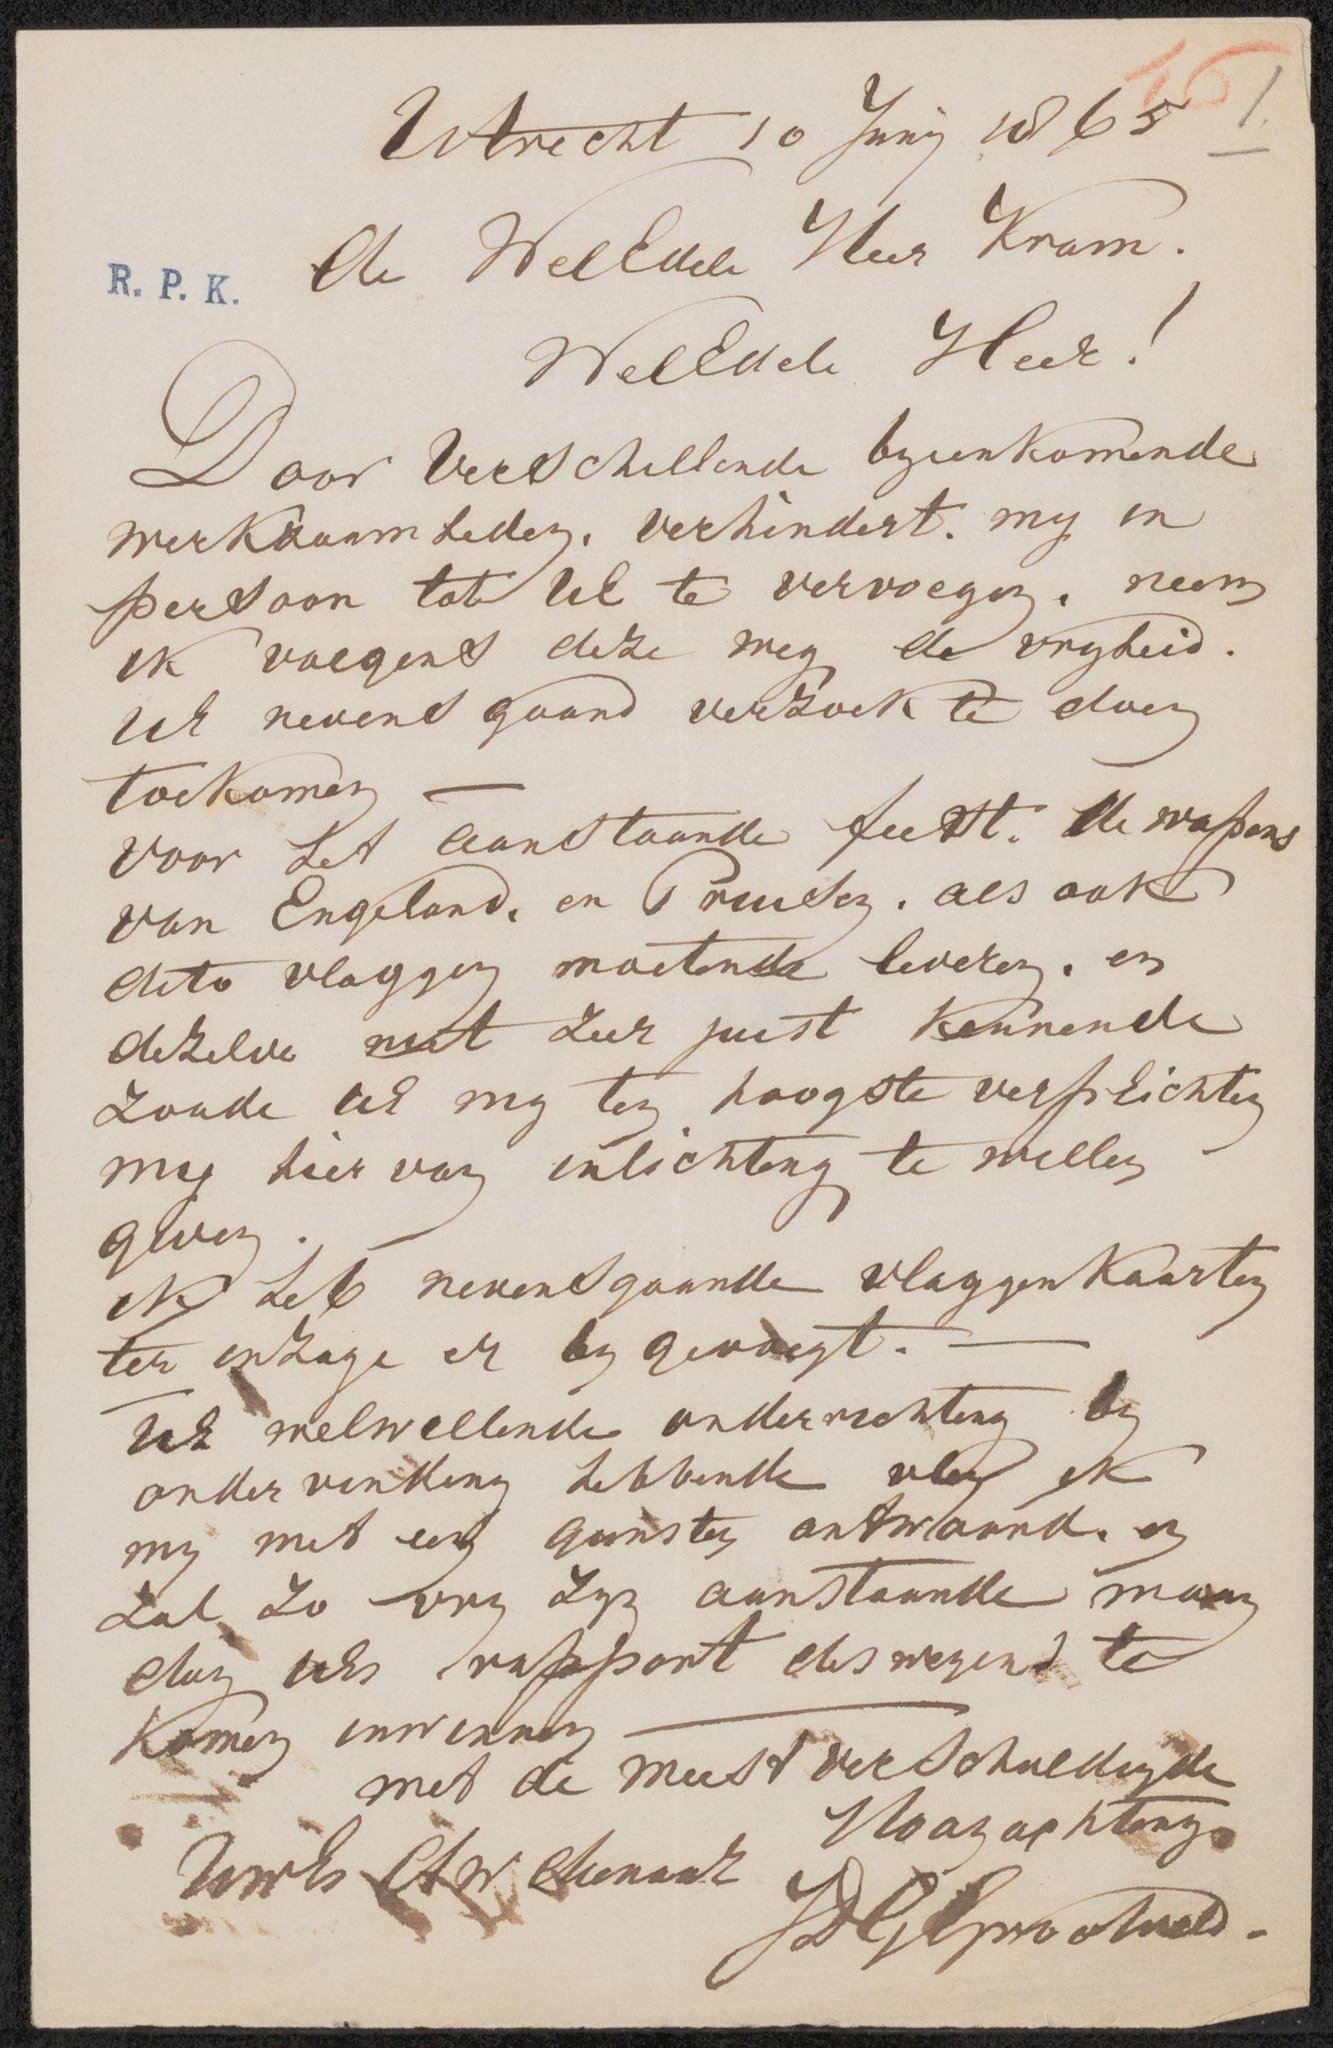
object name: letter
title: Brief aan Christiaan Kramm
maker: jan david geerling grootveld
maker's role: draughtsman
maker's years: 1821-1890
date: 1865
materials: ink, paper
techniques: pen, writing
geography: utrecht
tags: utrecht, draughtsman, christiaan kramm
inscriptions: collector's mark: Lugt 2233, seal